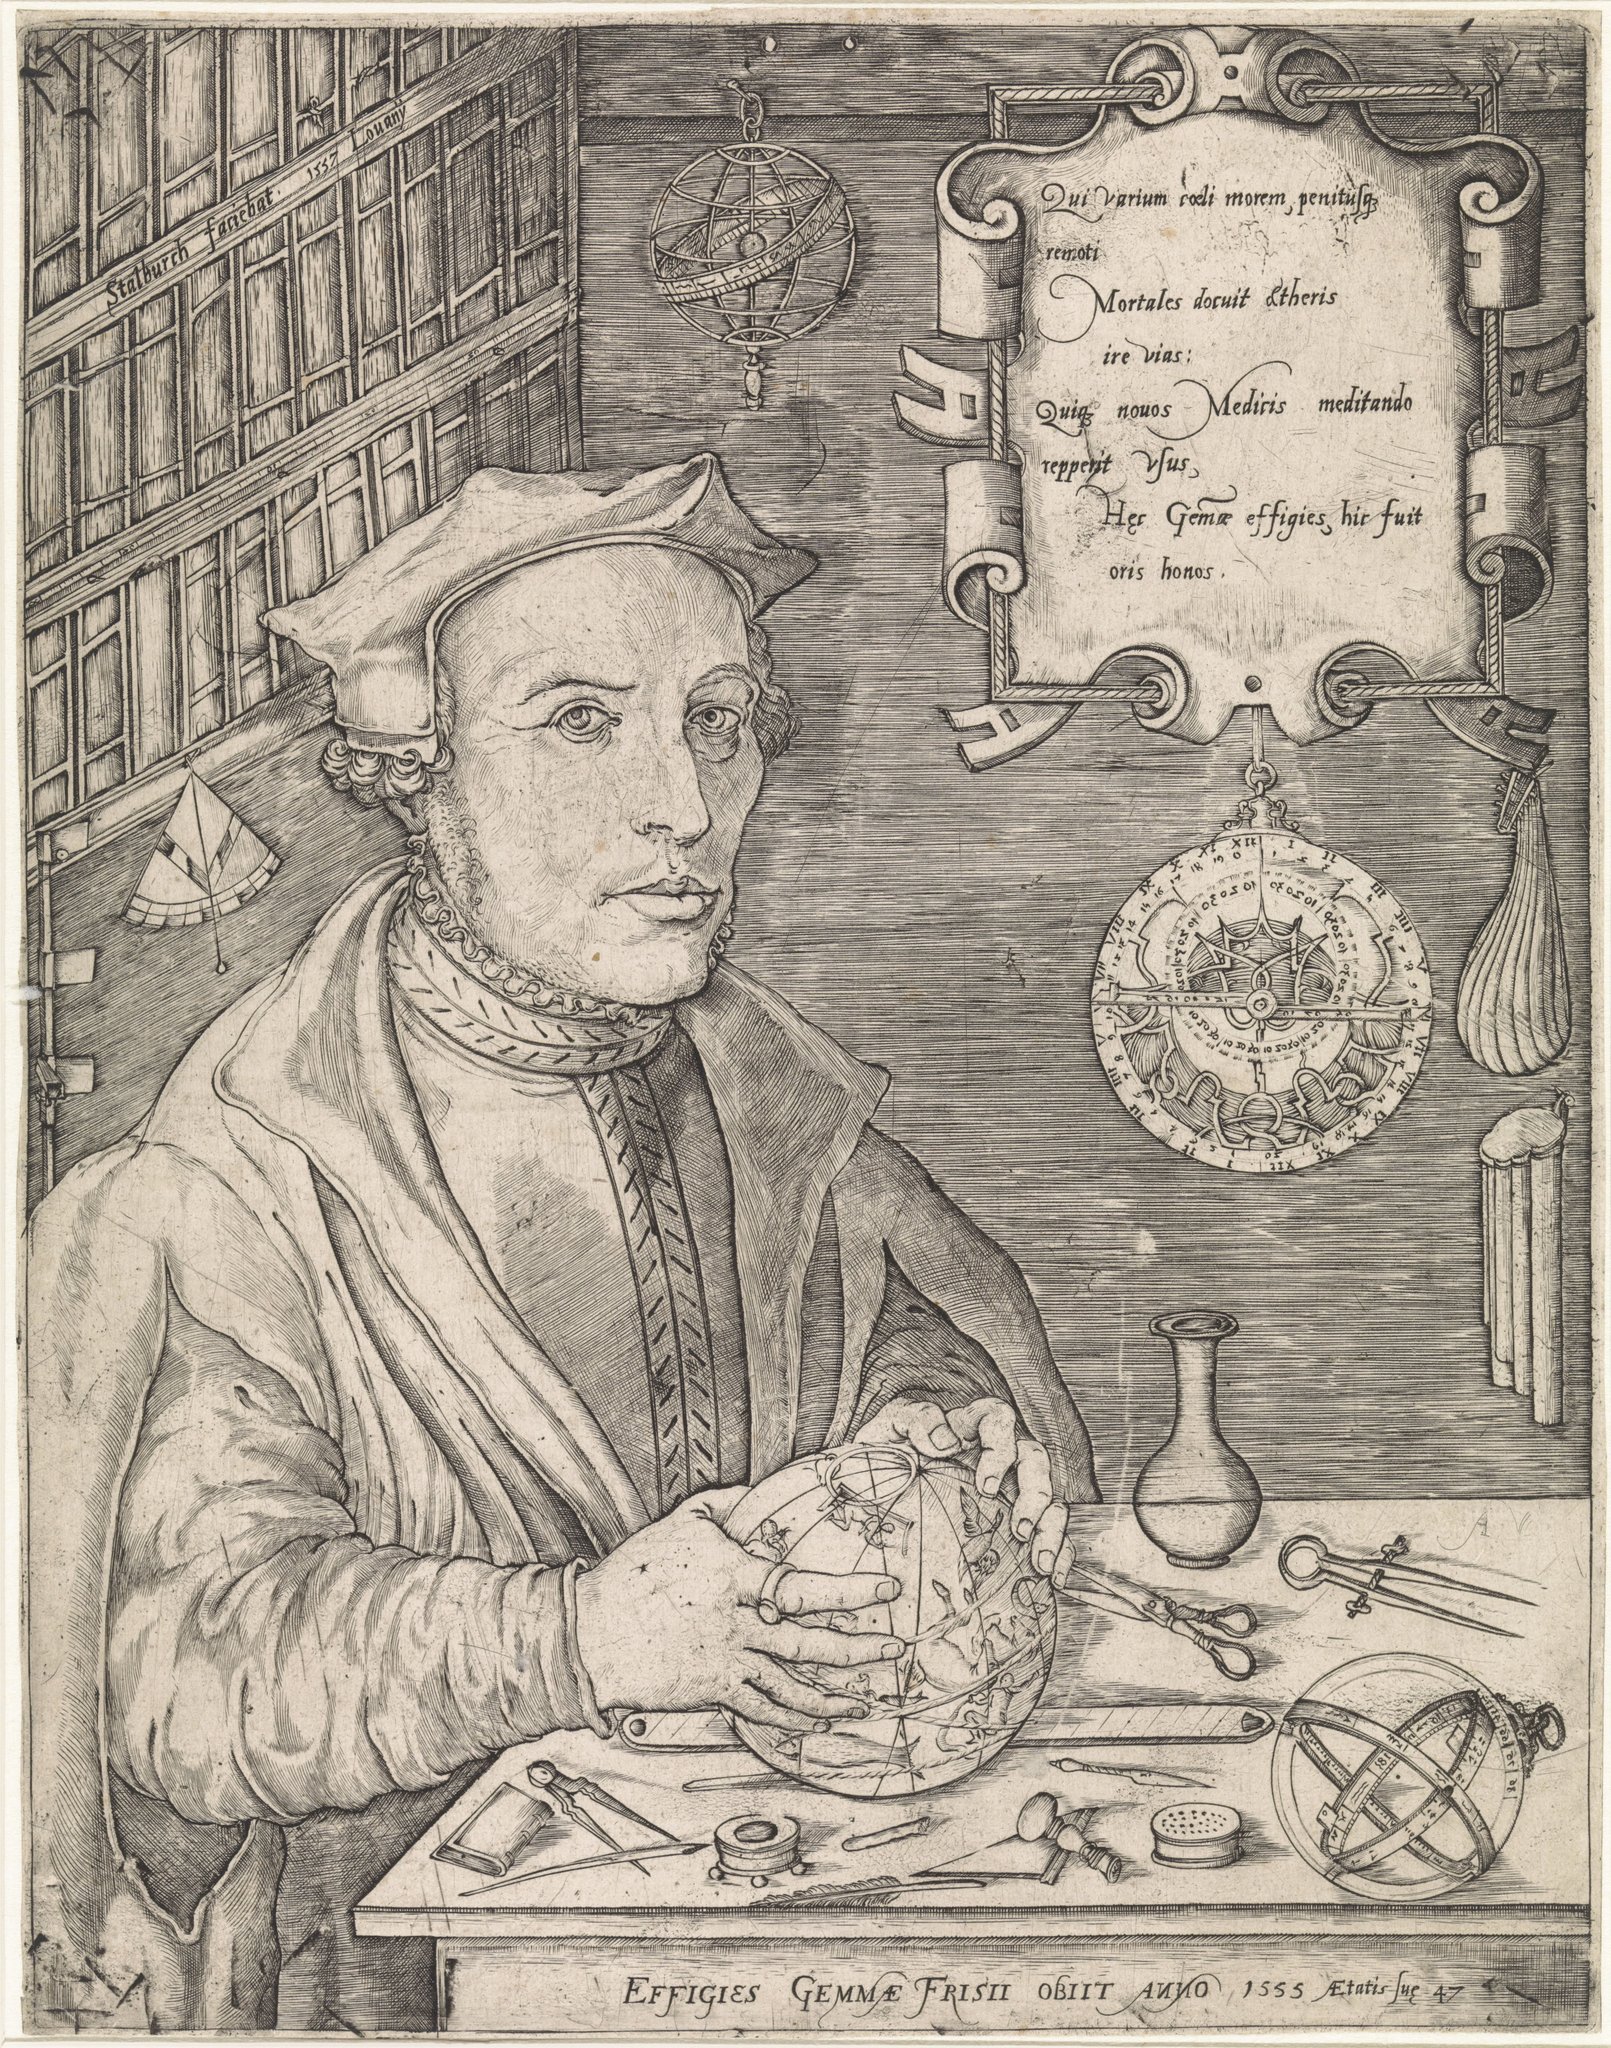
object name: print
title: Portret van Gemma Frisius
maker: jan van stalburch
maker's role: print maker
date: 1557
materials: paper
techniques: engraving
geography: leuven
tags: louvain, scholar in his study, astronomical instruments, armillary sphere, skeleton celestial globe, science and technology (+ portrait of scholar, scientist)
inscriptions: collector's mark: Lugt 2228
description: Portret van de geleerde Gemma Frisius, die schreef over de grondbeginselen van de astronomie en de kosmografie. Frisius zit in zijn studeervertrek met boekenkast, aan een tafel waarop een globe en verschillende astronomische instrumenten liggen. Hij draagt een paltrok en mantel en op zijn hoofd een bonnet.